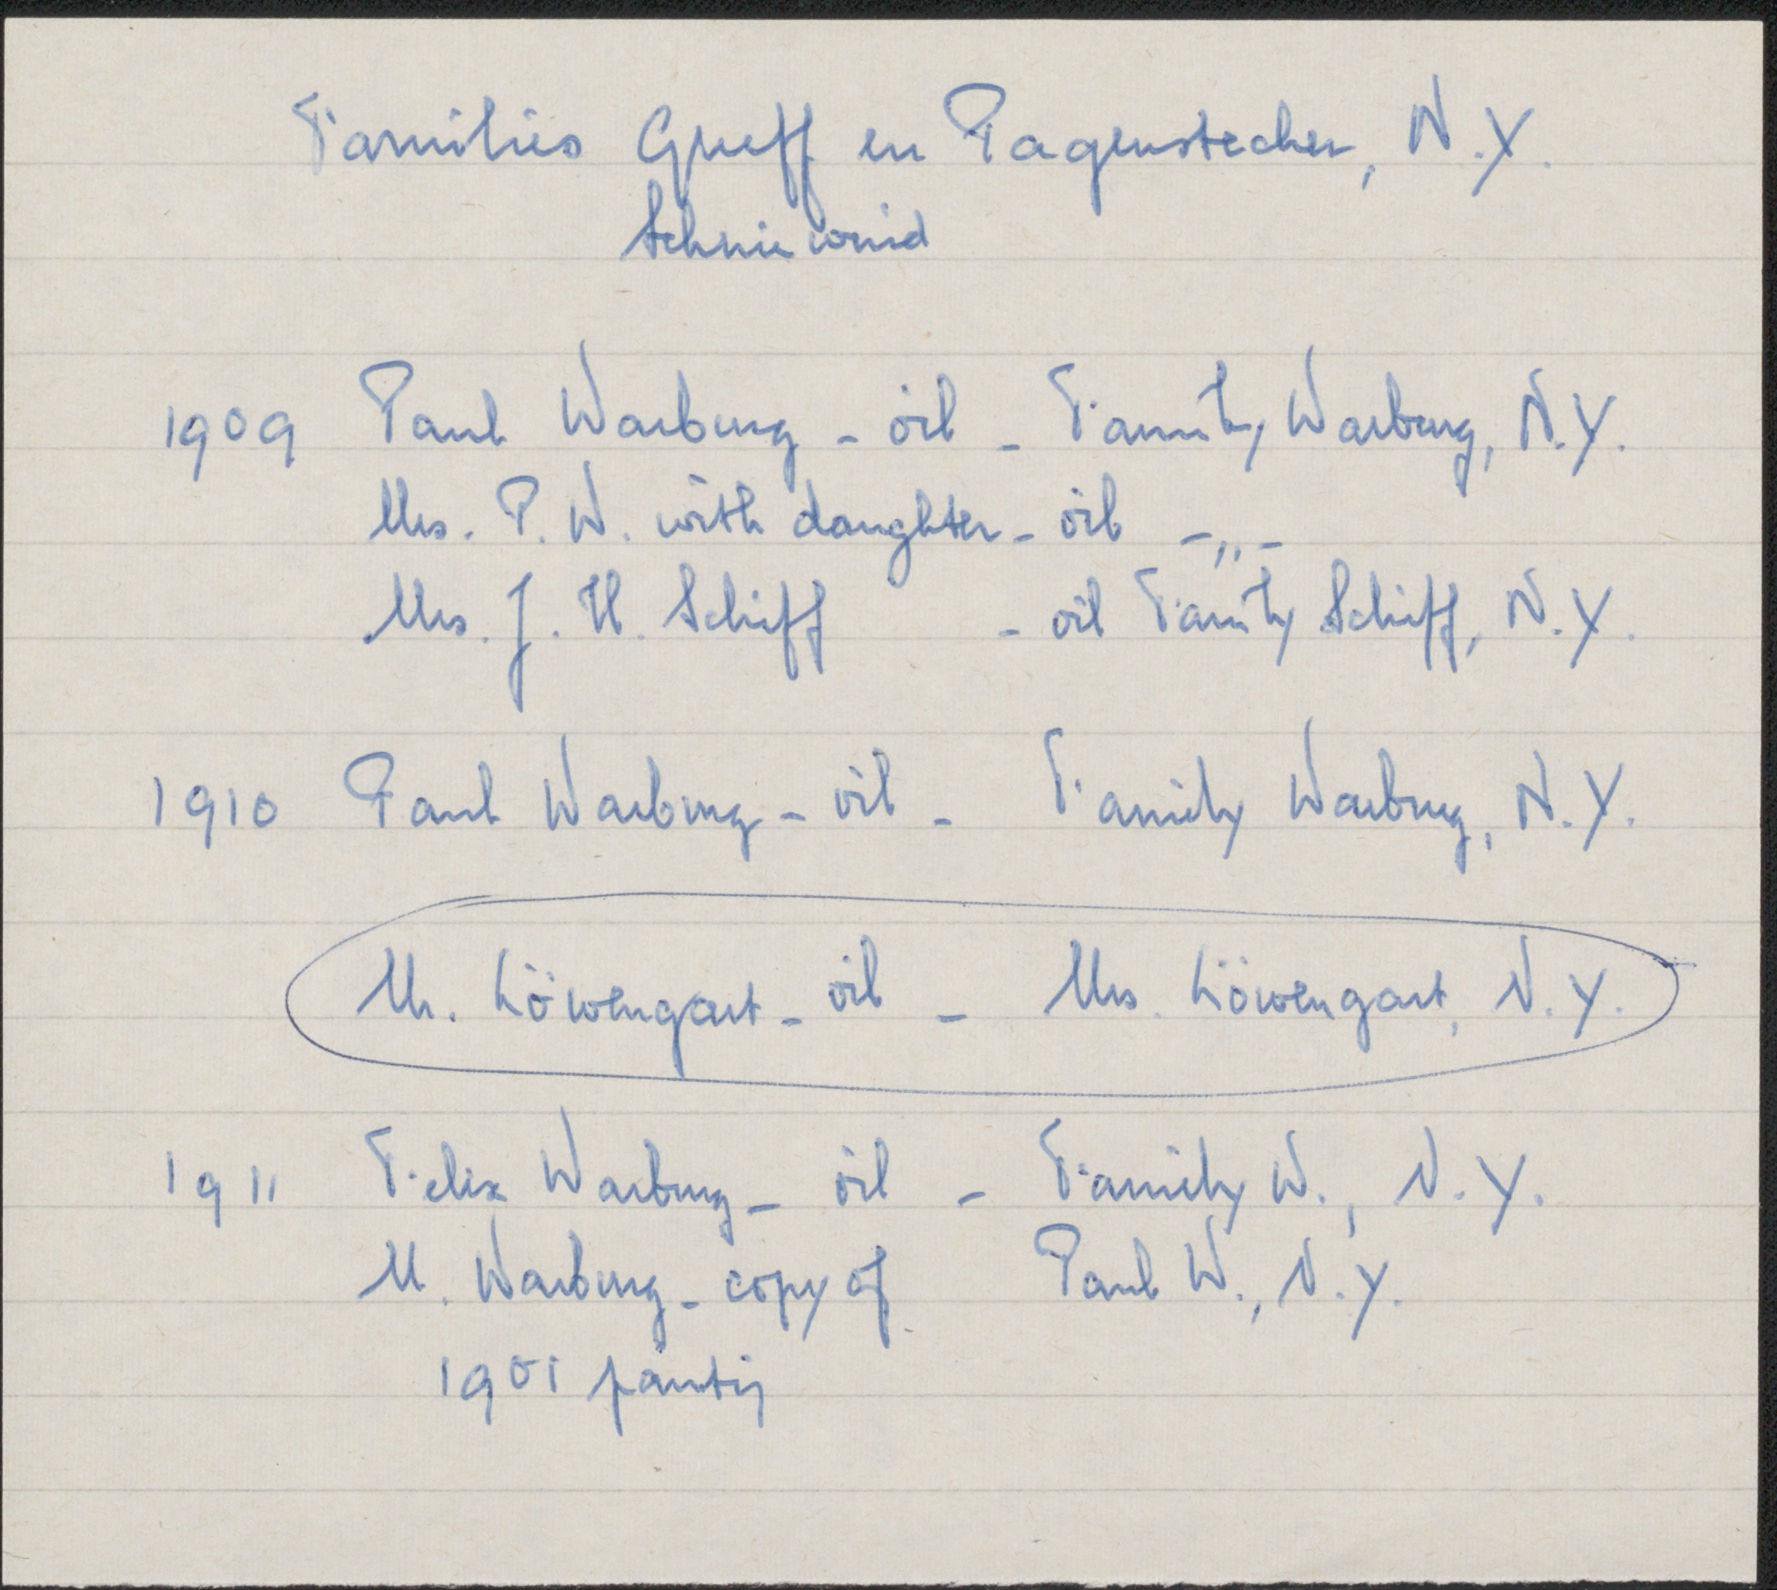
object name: aantekening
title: Aantekening uit archief Jan Veth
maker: Anonymous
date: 1874-1925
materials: ink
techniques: pen, writing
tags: dordrecht, amsterdam, painter, print maker, draughtsman, designer, jan veth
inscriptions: collector's mark: ‘RPK’